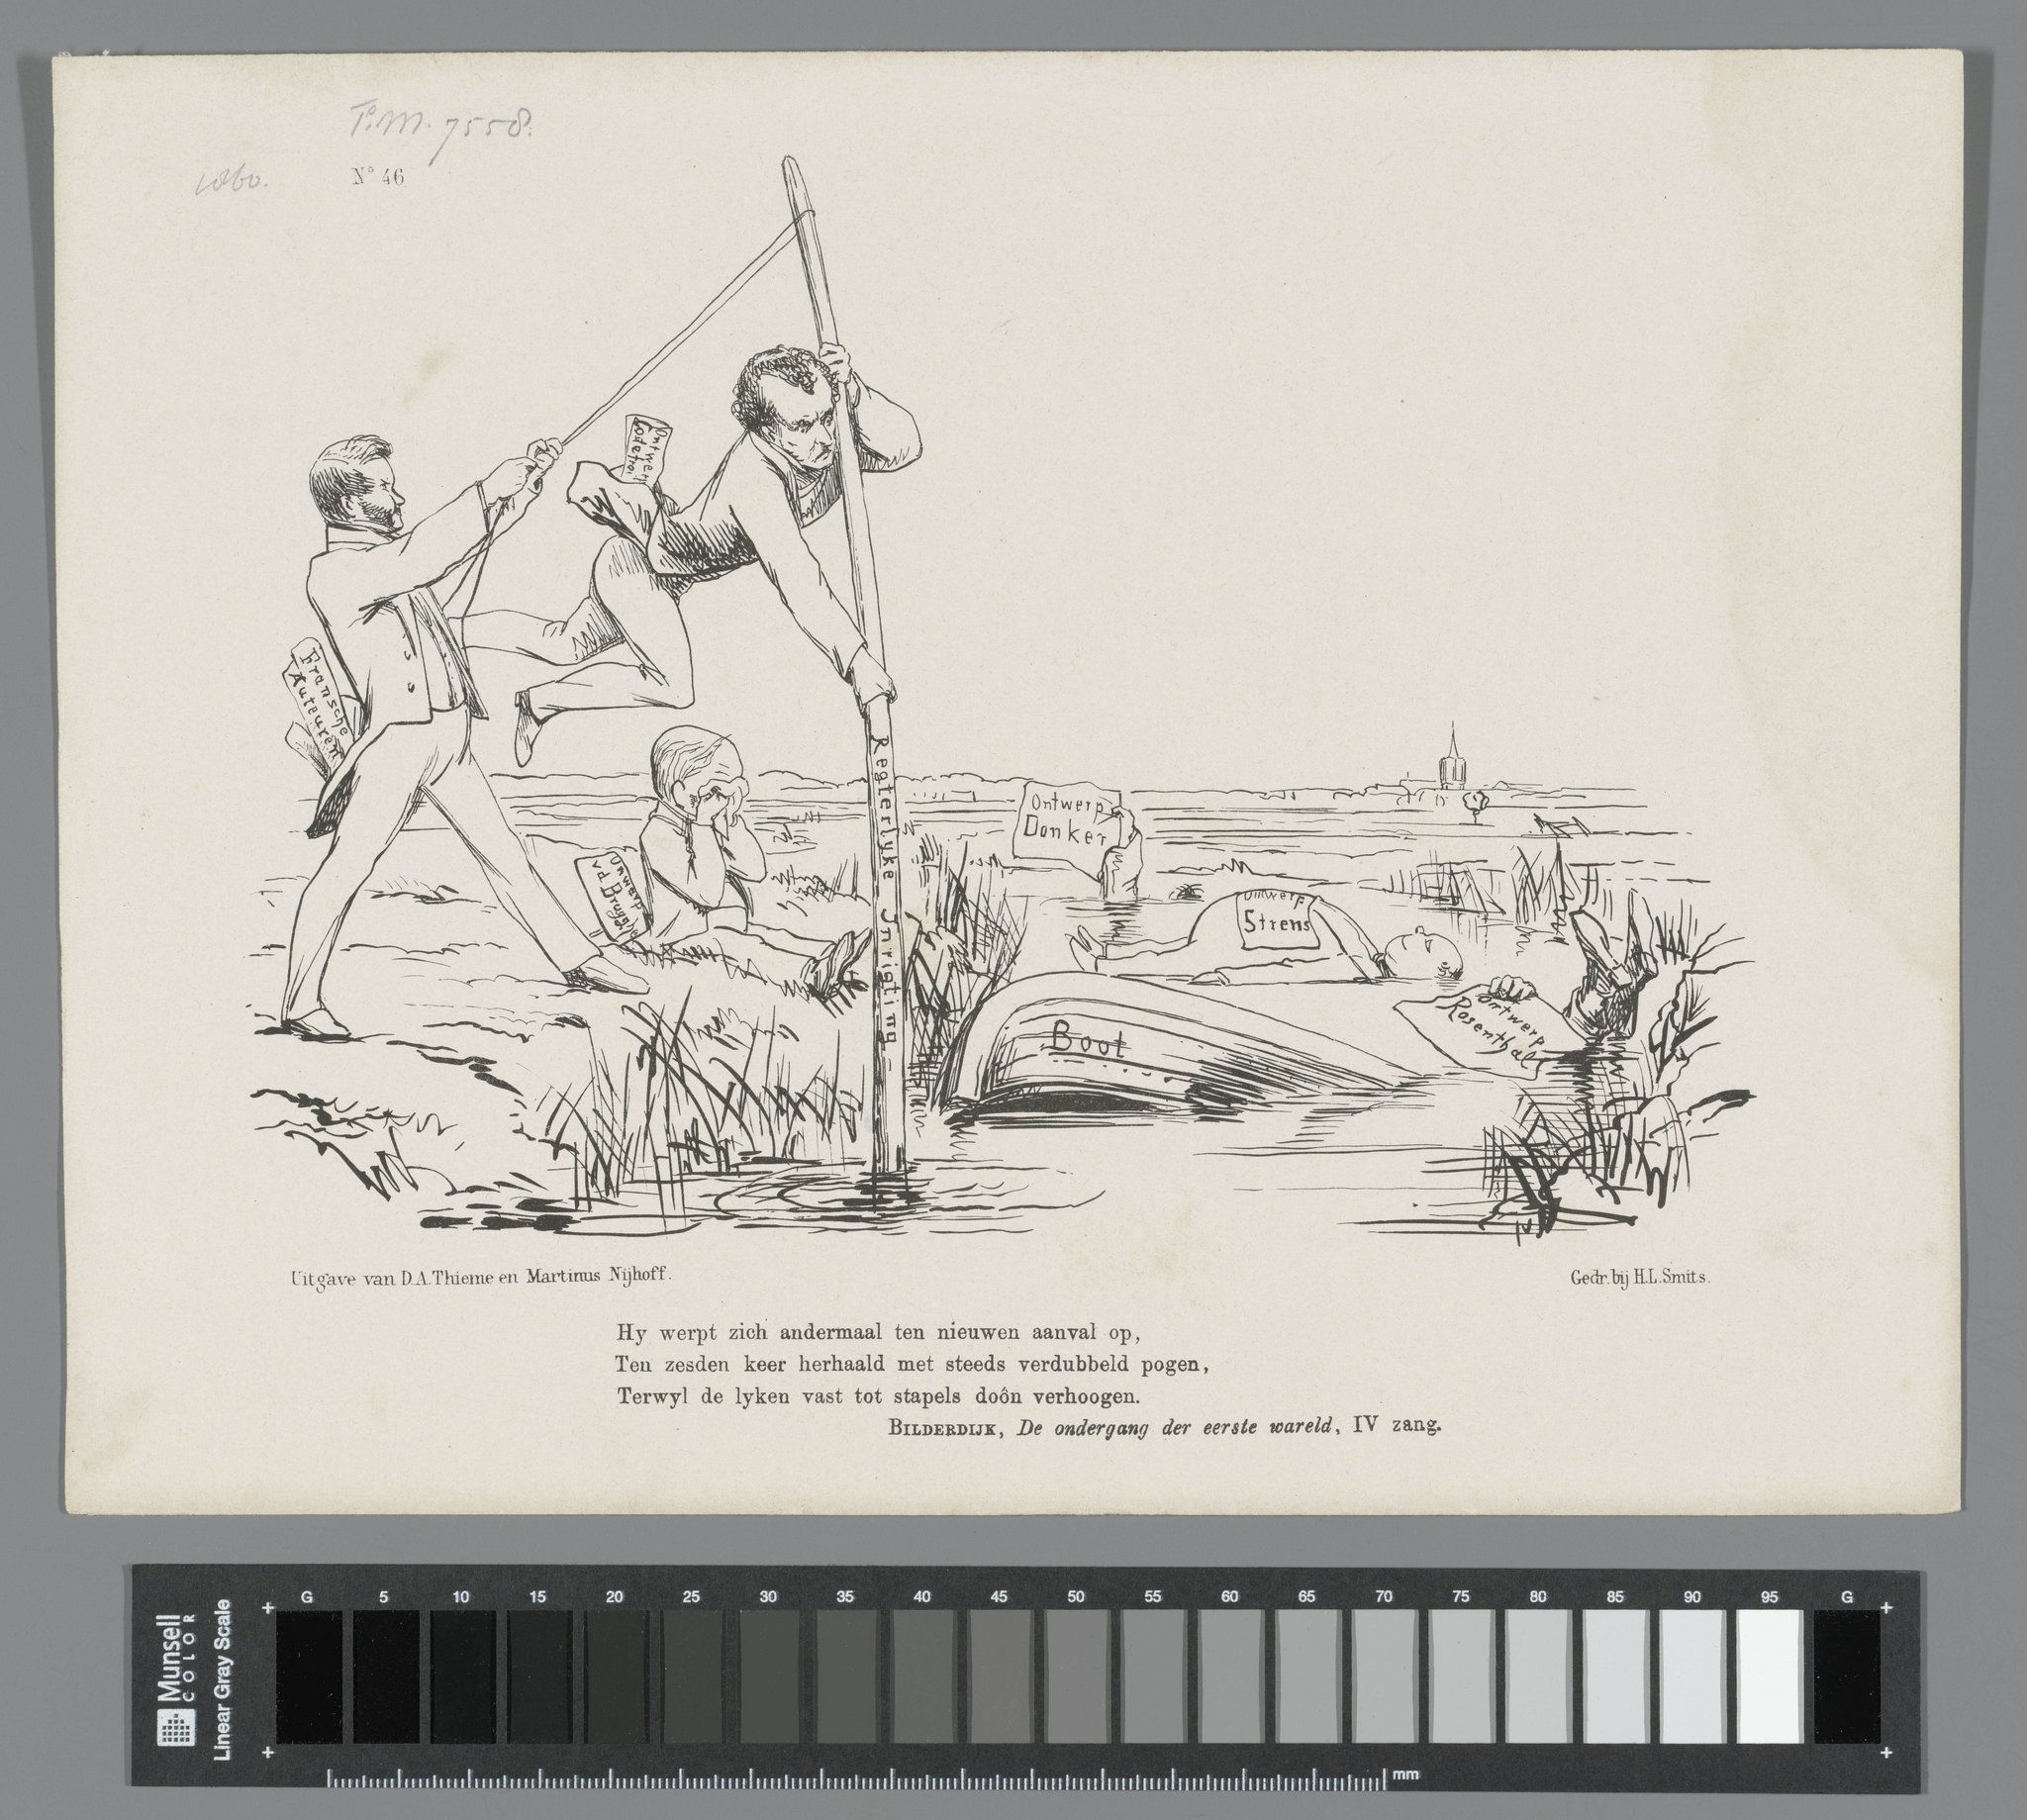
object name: print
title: Spotprent op de minister M.H. Godefroi, 1860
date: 1860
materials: paper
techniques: lithograph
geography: the hague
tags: ditch-over with jumping pole (jumping game)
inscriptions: collector's mark: Lugt 2228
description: Spotprent op de Minister van Justitie M.H. Godefroi die met een polsstok over een sloot probeert te springen, waar zijn voorgangers in het water zijn beland. Zie voor het vervolg platen 48 en 23 (1861). Plaat verschenen bij het weekblad De Nederlandsche Spectator, nr. 46, 17 november 1860.